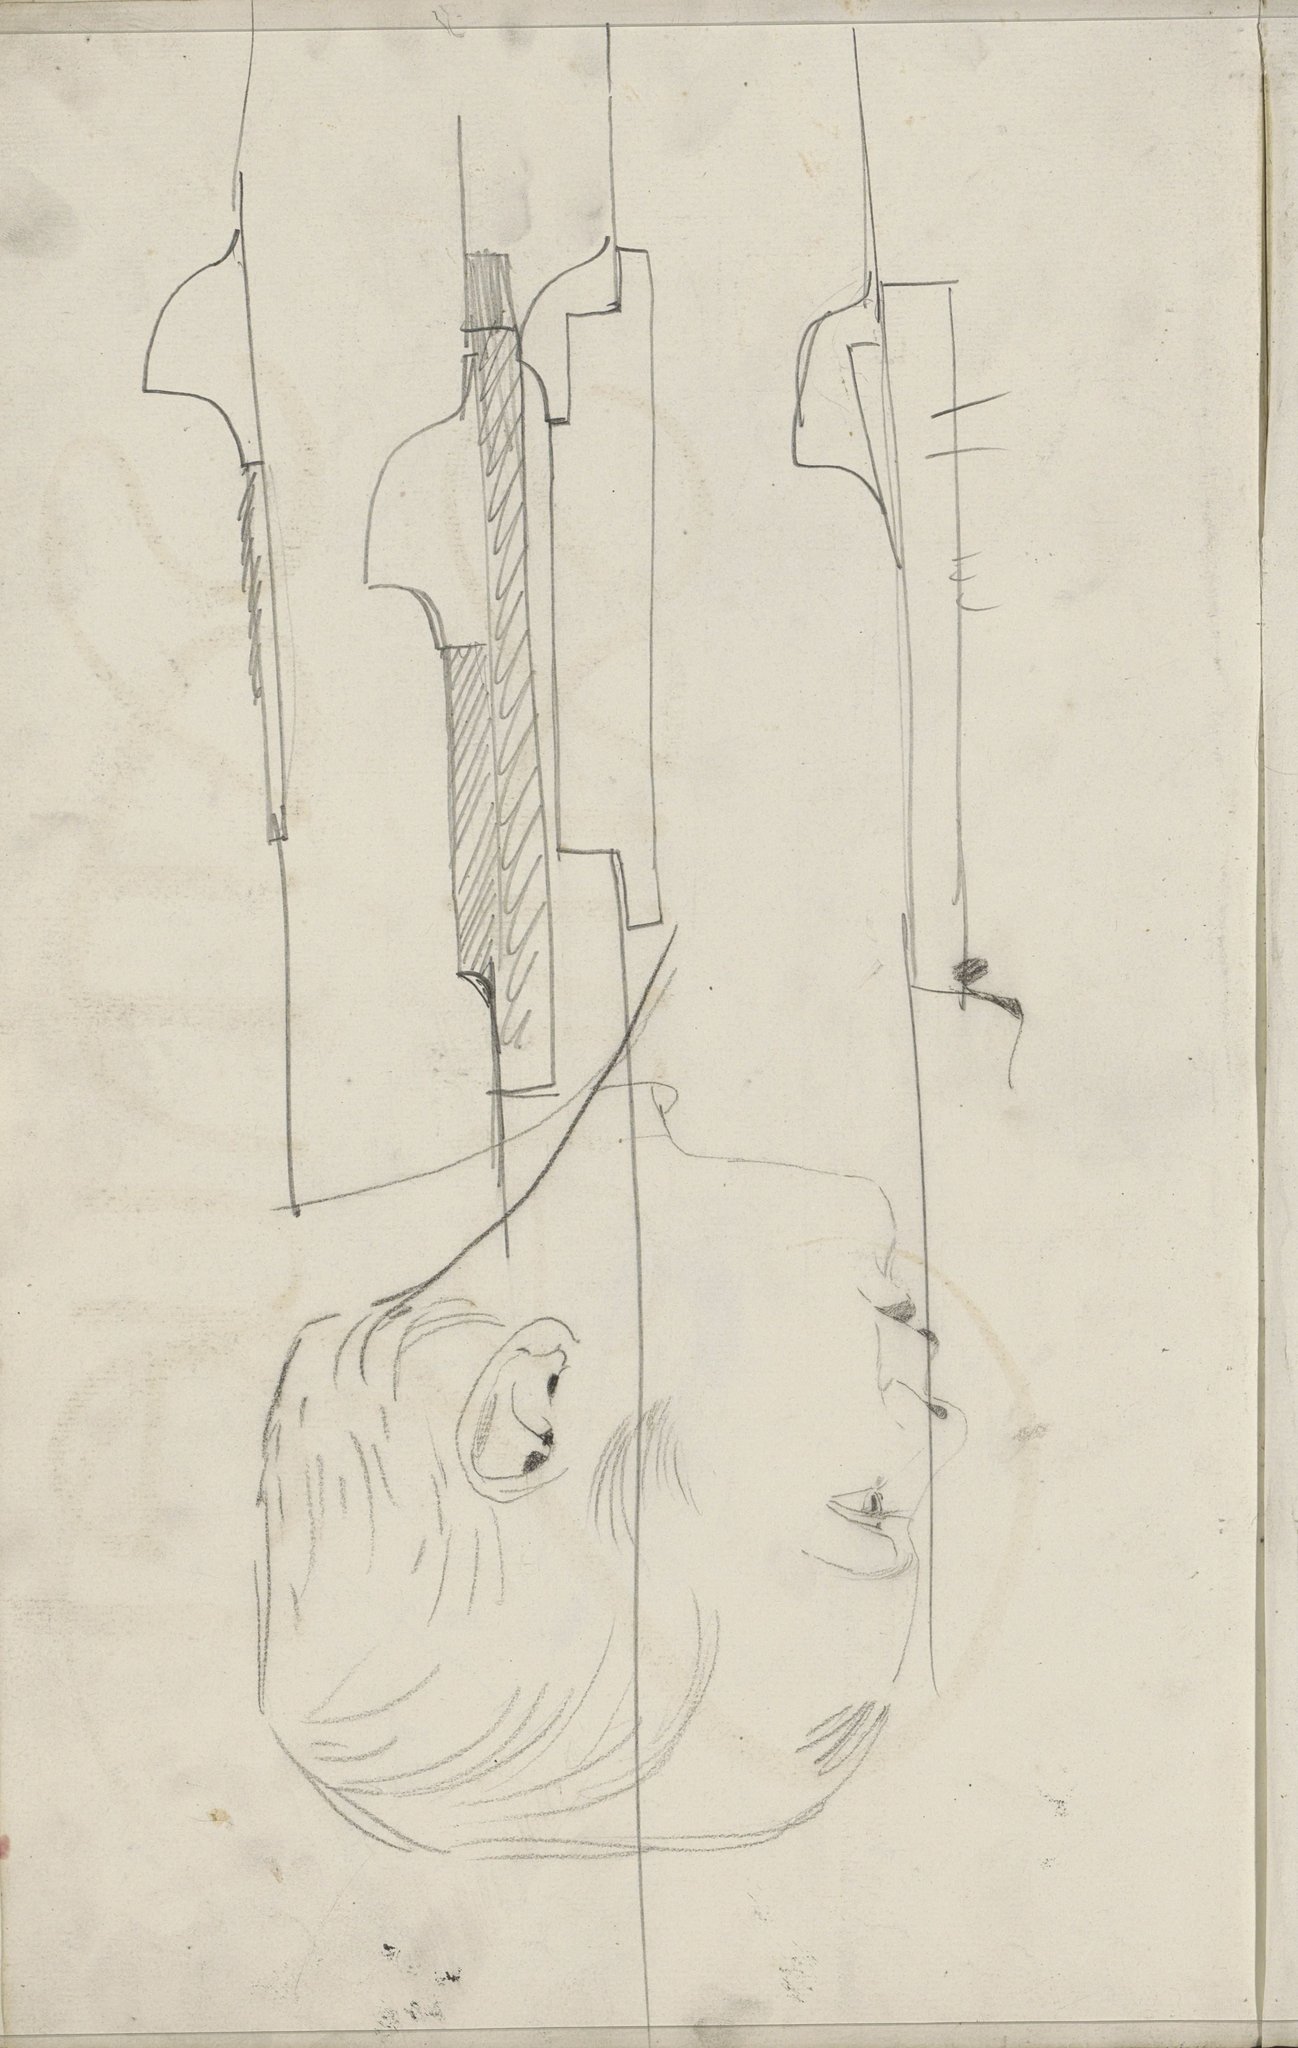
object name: sketchbook leaf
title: Portret van een jongen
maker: carel adolph lion cachet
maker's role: draughtsman, print maker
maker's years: 1864-1945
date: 1895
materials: chalk, paper, pencil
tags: boy (child between toddler and youth)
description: Tevens studies, mogelijk van architectuurdetails. Blad 6 verso uit een schetsboek met 23 bladen.